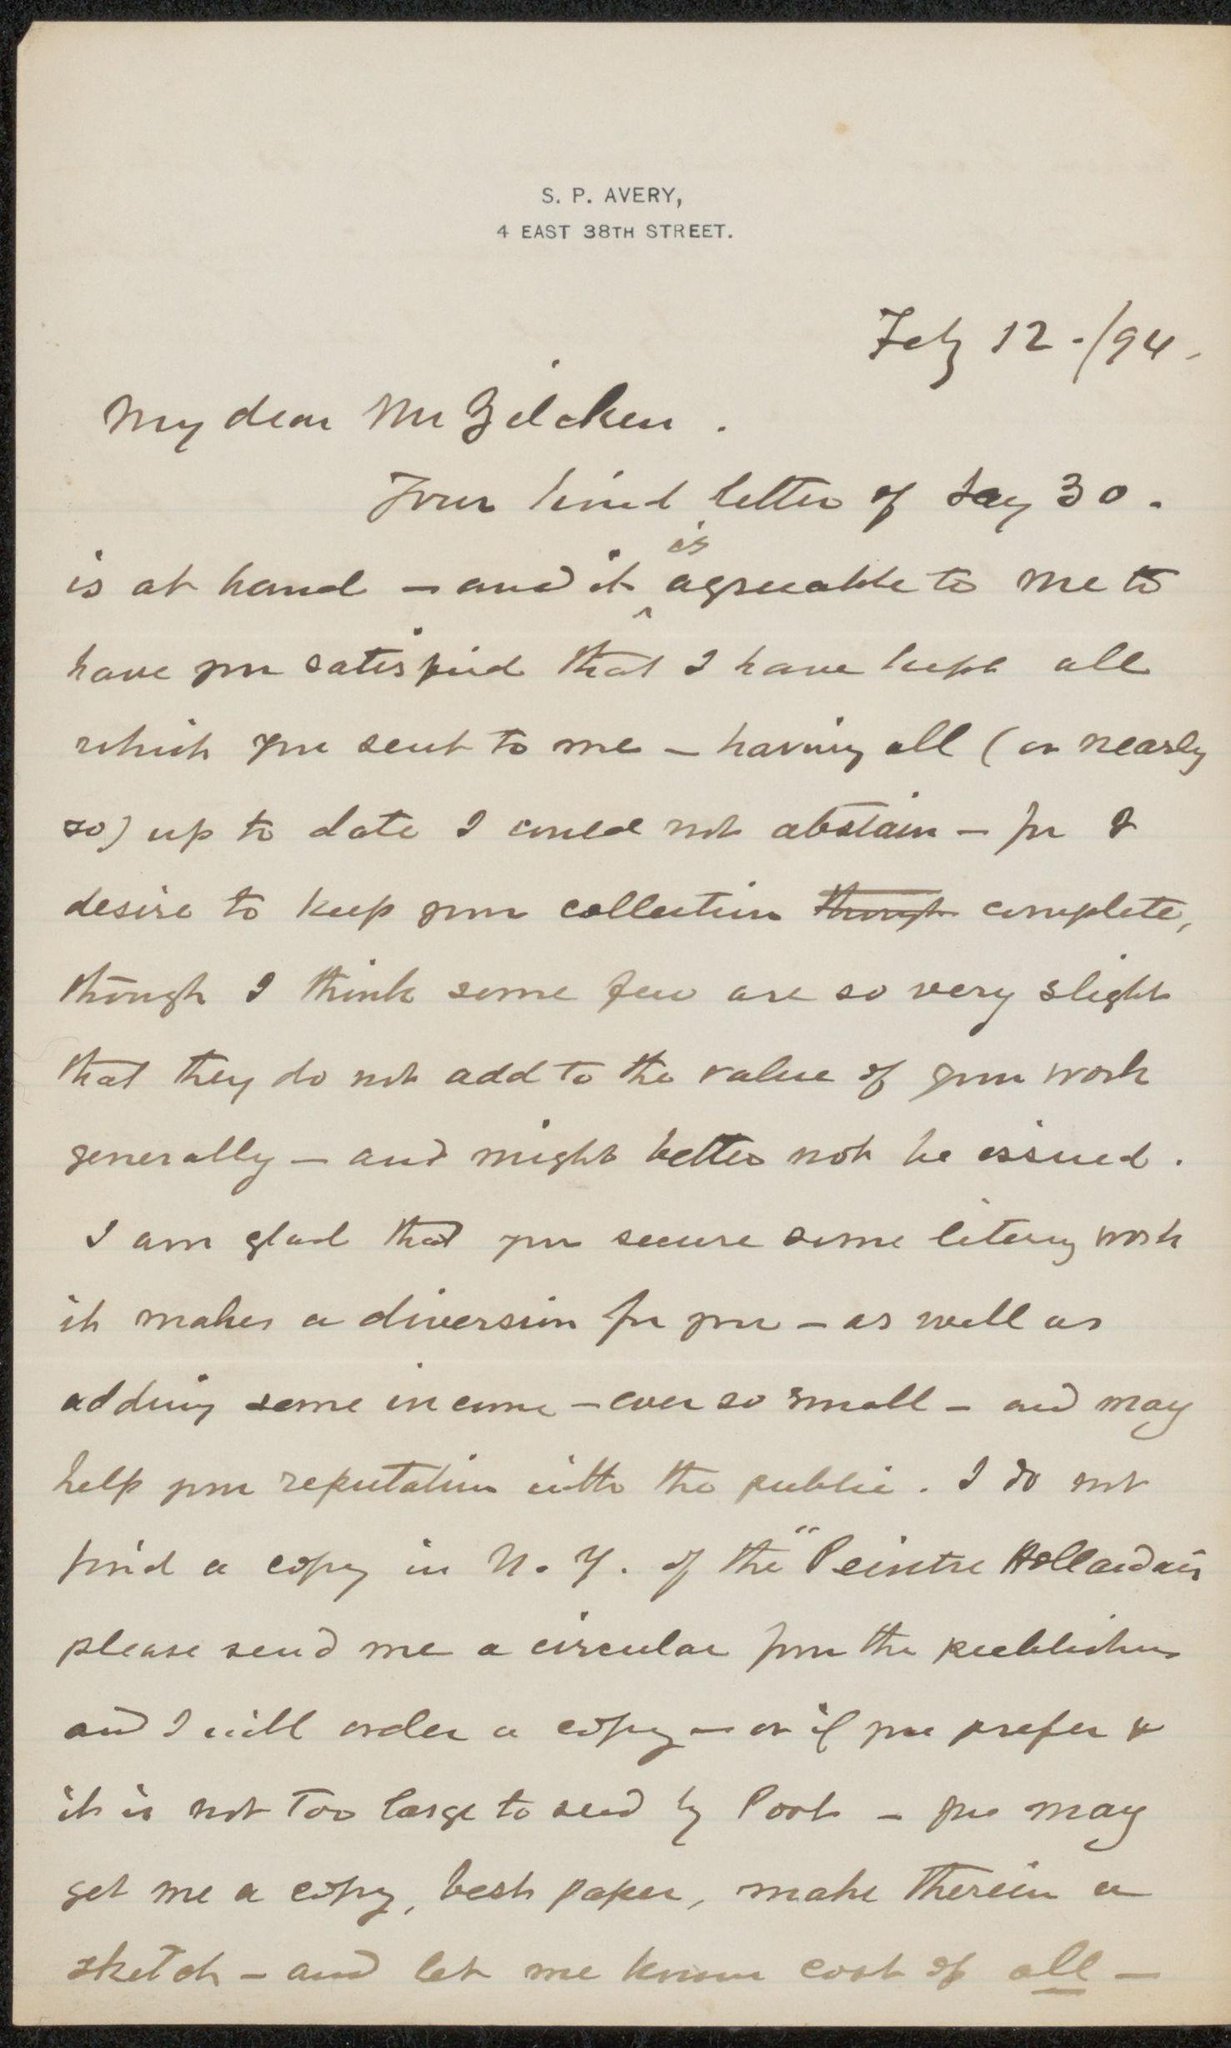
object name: letter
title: Brief aan Philip Zilcken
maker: samuel putnam avery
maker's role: verzamelaar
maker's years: 1822-1904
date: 1894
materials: ink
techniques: pen, printing, writing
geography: new york city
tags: arnhem, painter, print maker, draughtsman, anton mauve, william macbeth, the hague, philip zilcken, art trade, art shop, the graphic arts, art collecting, historical persons (portraits and scenes from the life)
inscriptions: collector's mark: ‘RPK’